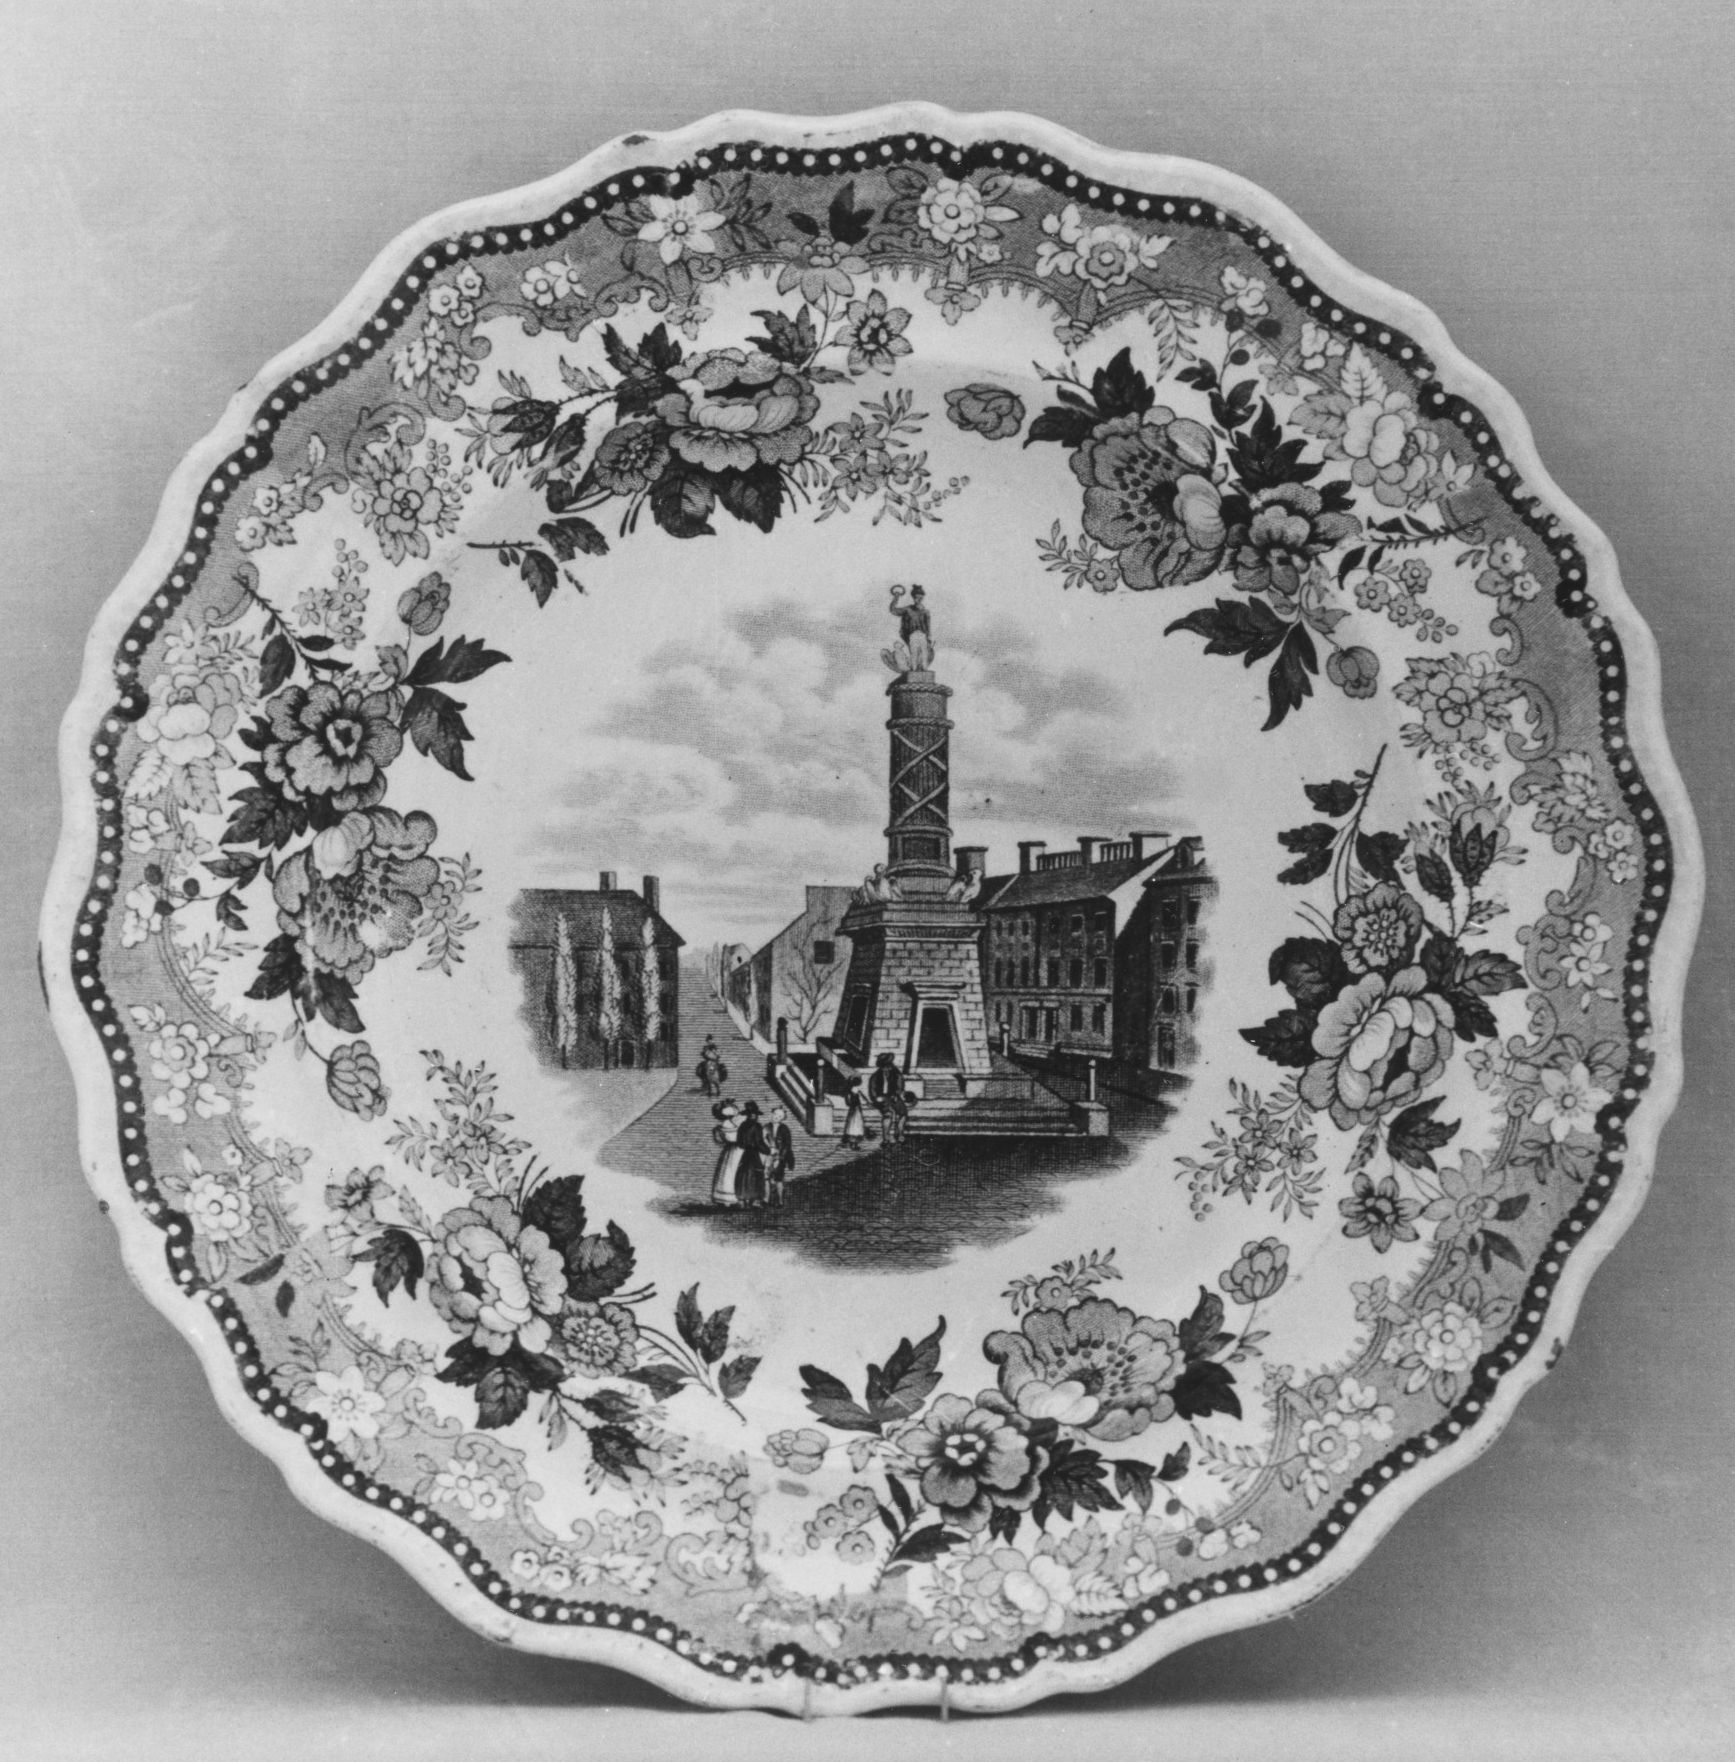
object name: plate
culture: british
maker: job & john jackson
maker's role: maker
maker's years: 1831-1835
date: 1831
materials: earthenware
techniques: transfer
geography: england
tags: monuments